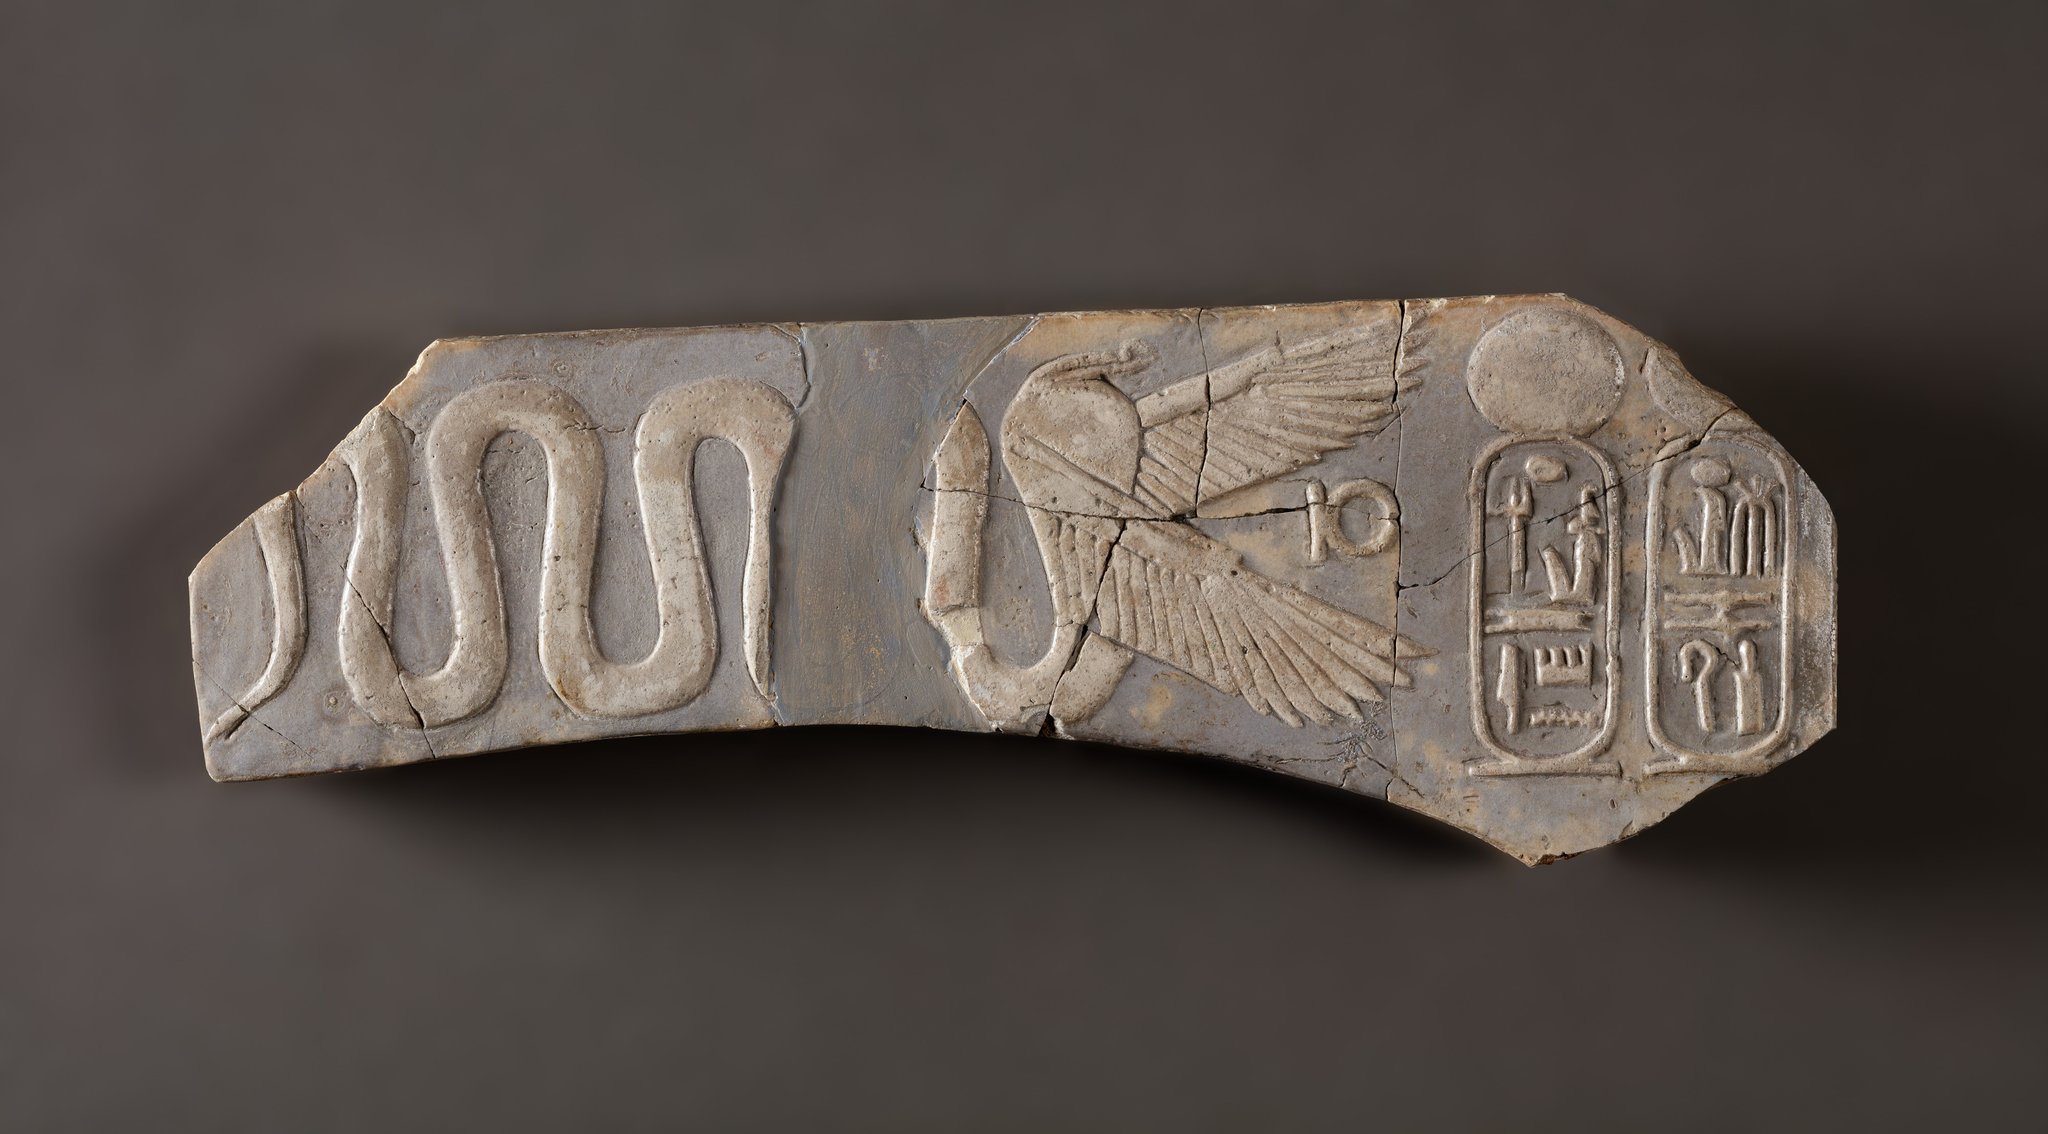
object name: tile, winged serpent, ramesses iii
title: Winged serpent with the cartouches of Ramesses III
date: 1184-1153 BCE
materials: faience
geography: egypt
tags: cartouches,hieroglyphs,serpents